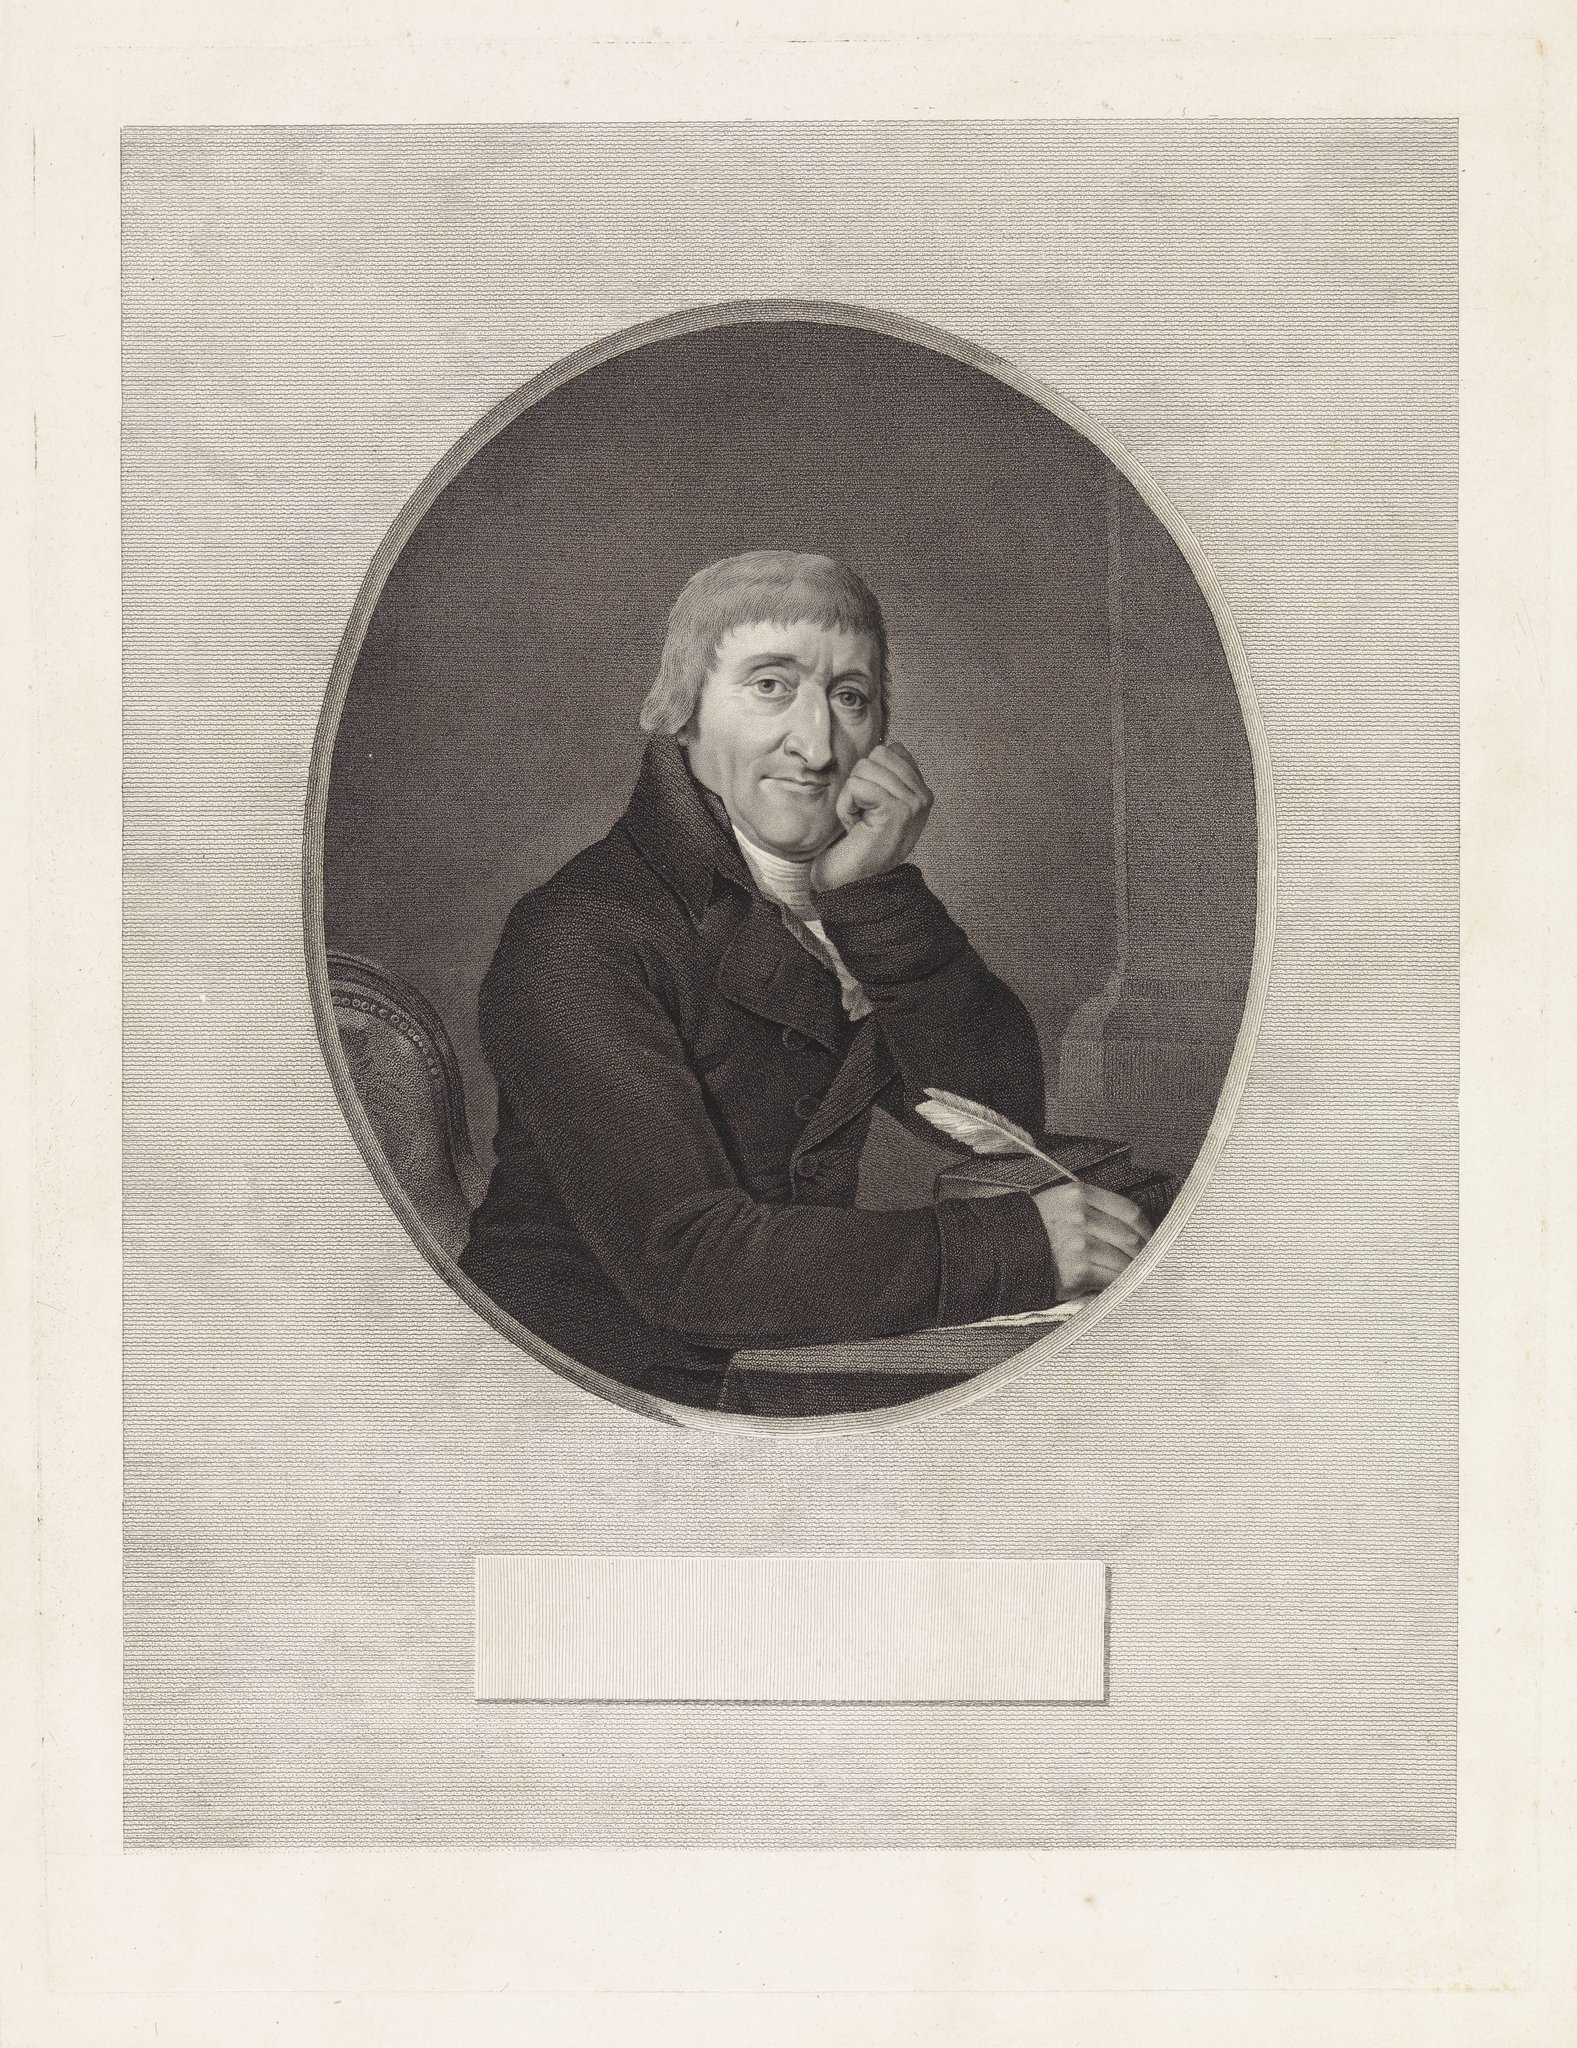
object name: print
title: Portret van de medicus Johan Rudolph Deiman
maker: ludwig gottlieb portman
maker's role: print maker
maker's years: 1772-1828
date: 1787-1828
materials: paper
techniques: stippled etching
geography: amsterdam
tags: amsterdam, writing tools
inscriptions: collector's mark: Lugt 2228